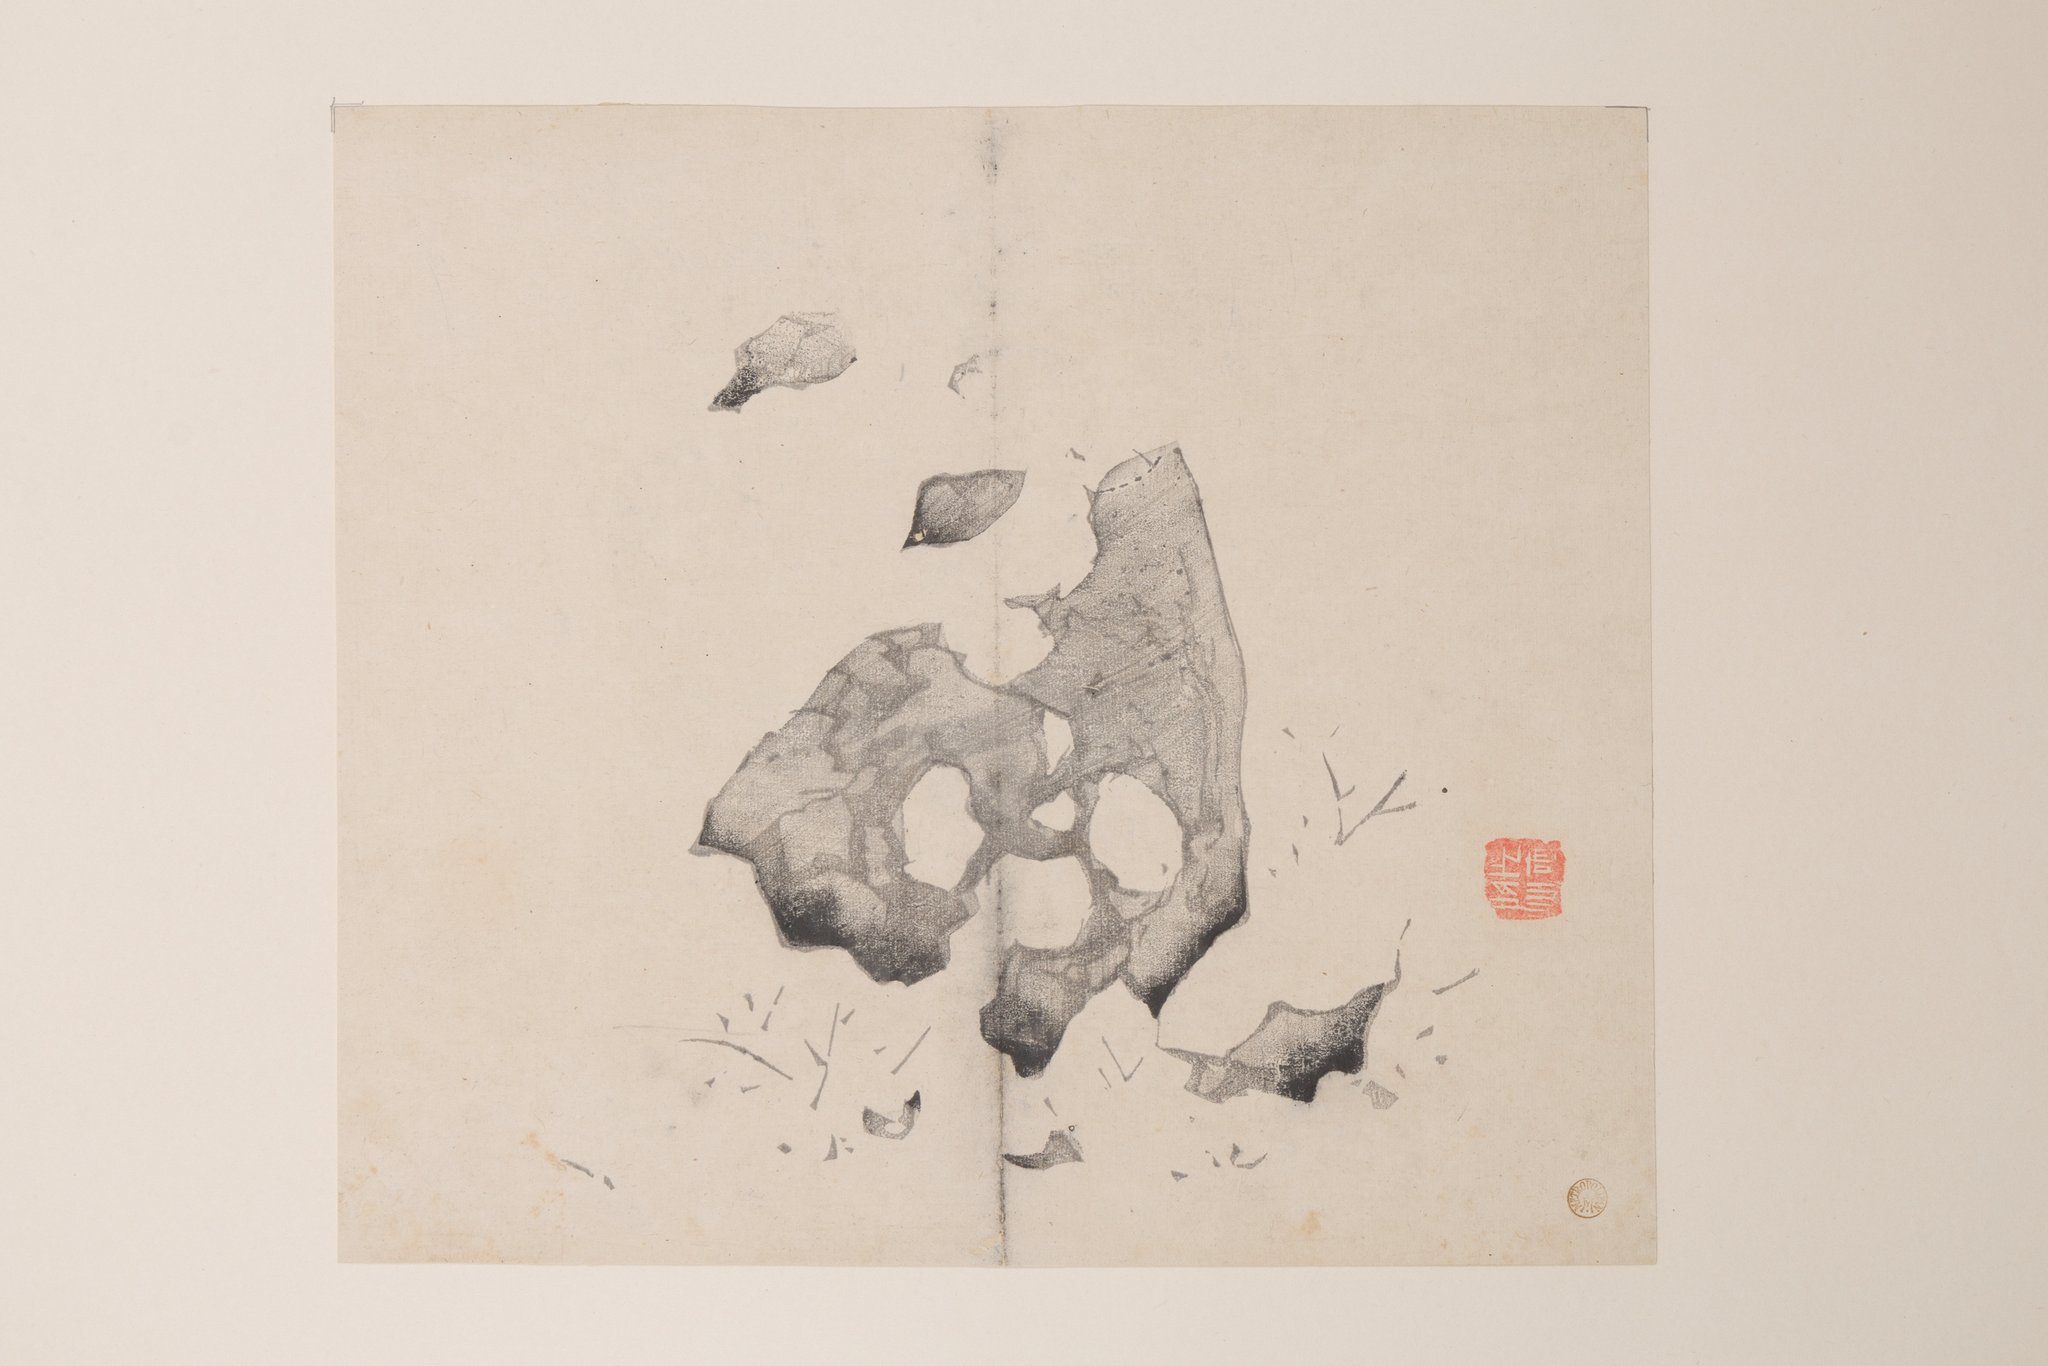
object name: print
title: Page from the Ten Bamboo Studio Manual of Painting and Calligraphy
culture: chinese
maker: hu zhengyan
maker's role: artist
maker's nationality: chinese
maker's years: 1584-1634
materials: ink, paper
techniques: printing